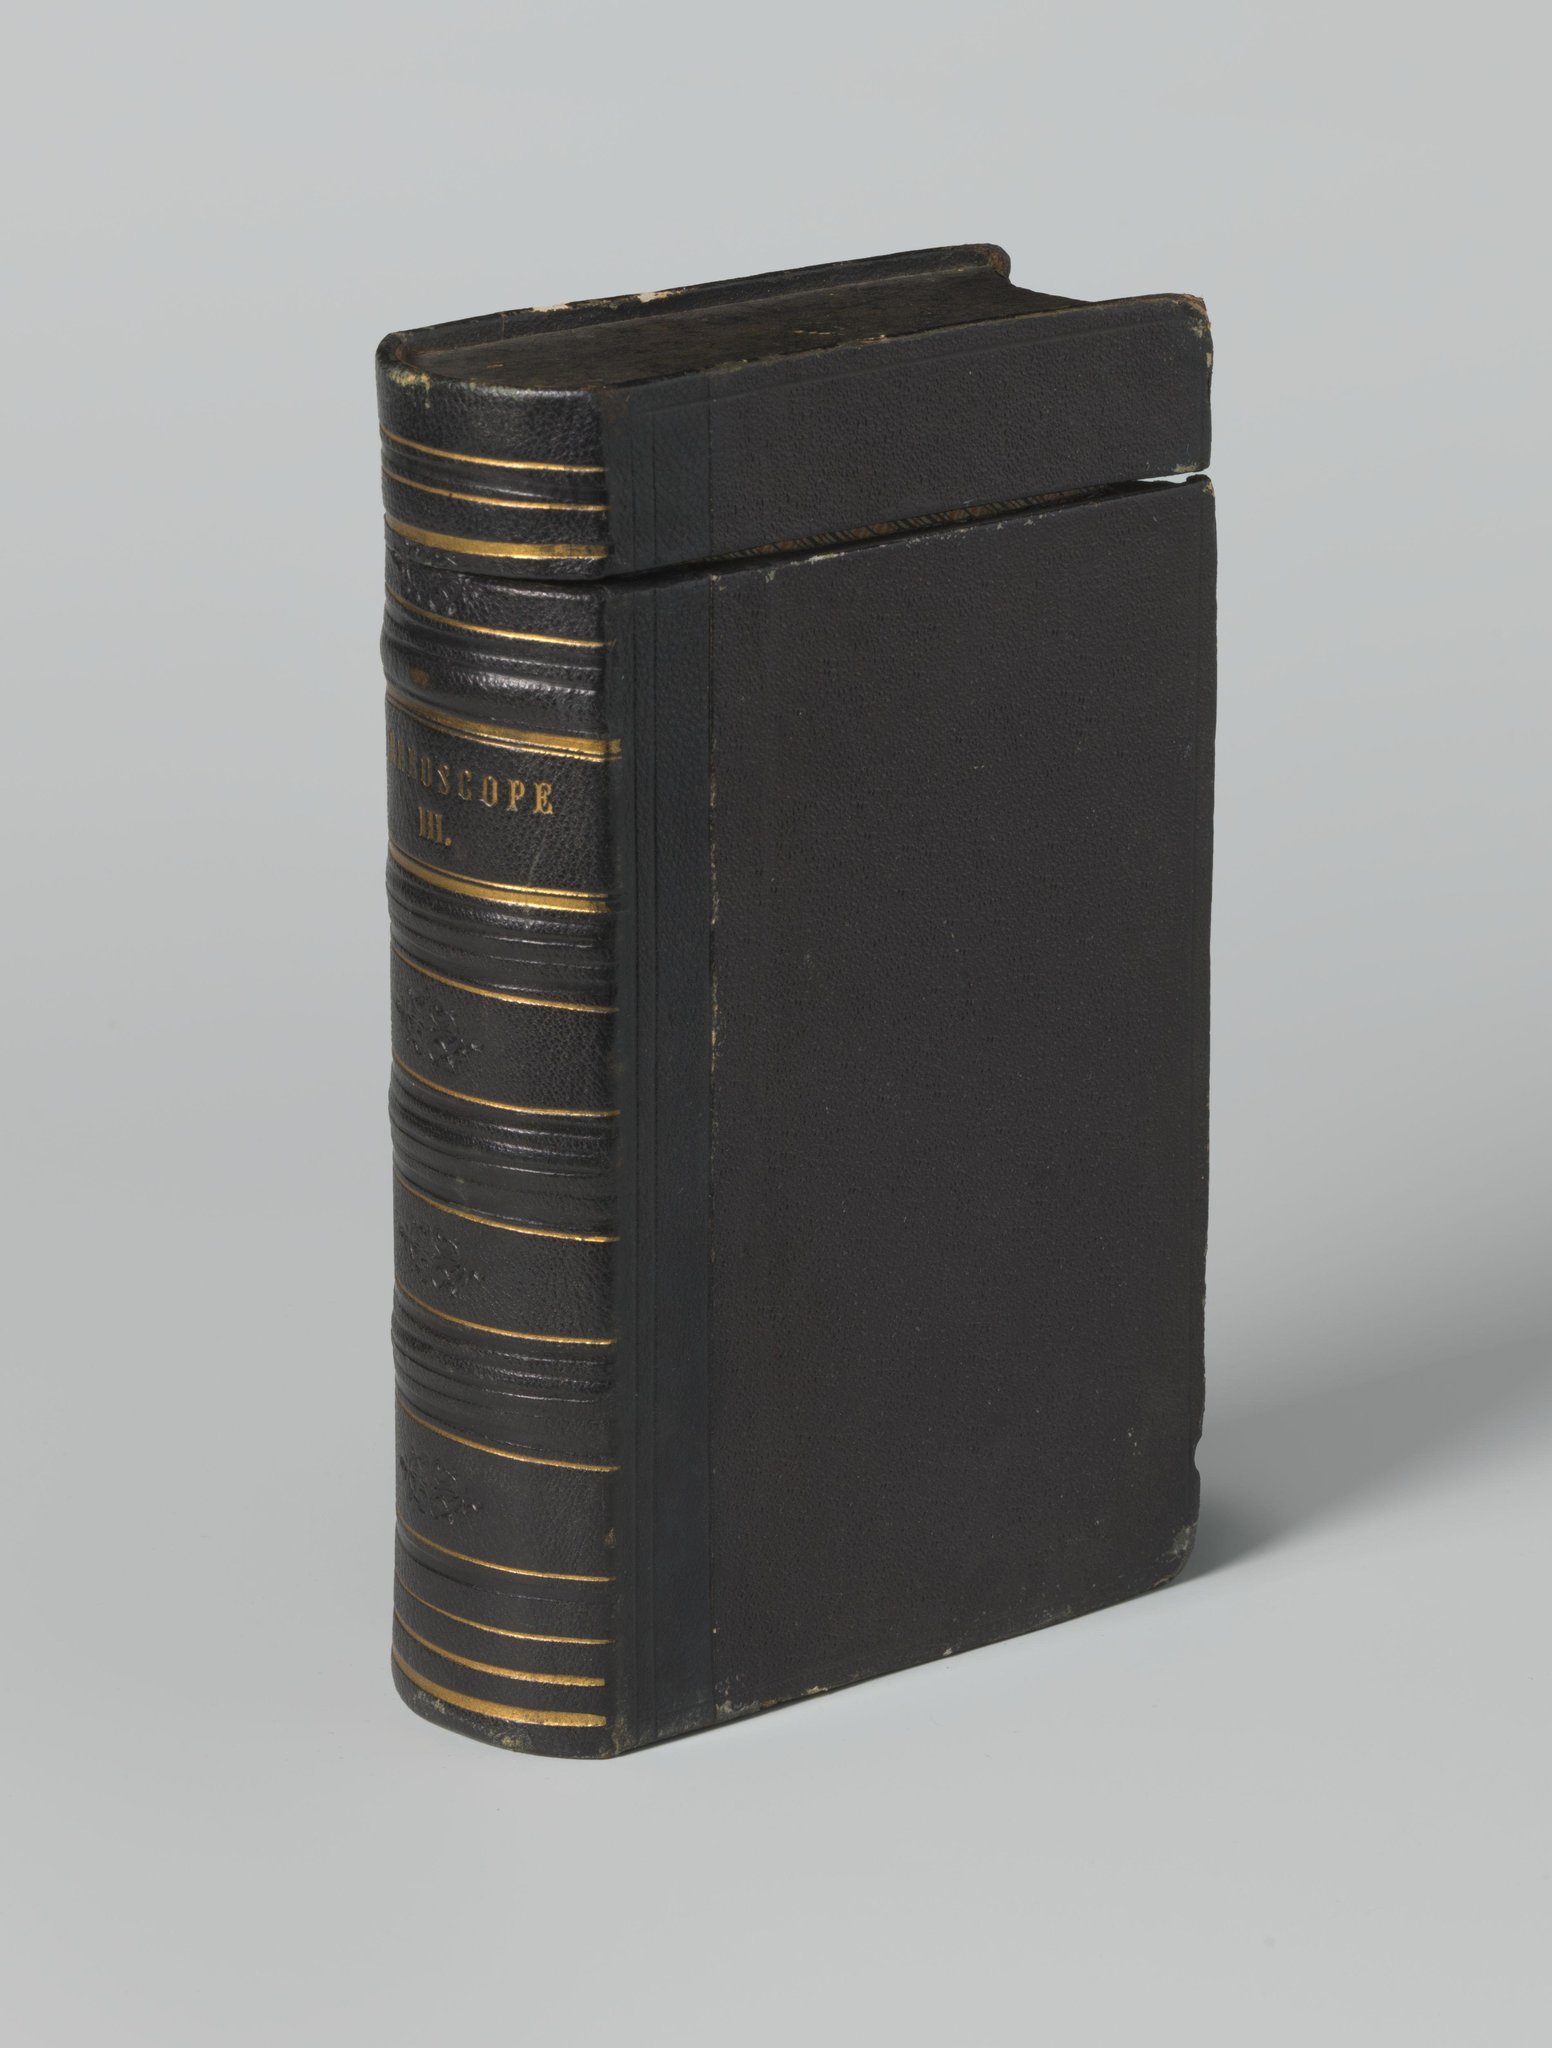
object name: box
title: Doos voor stereofoto's in de vorm van een boek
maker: Anonymous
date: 1860-1900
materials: cardboard, leather, paper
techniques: marbling, marbled paper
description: Doos in de vorm van boekband, voor het opbergen van stereofoto's (leeg).